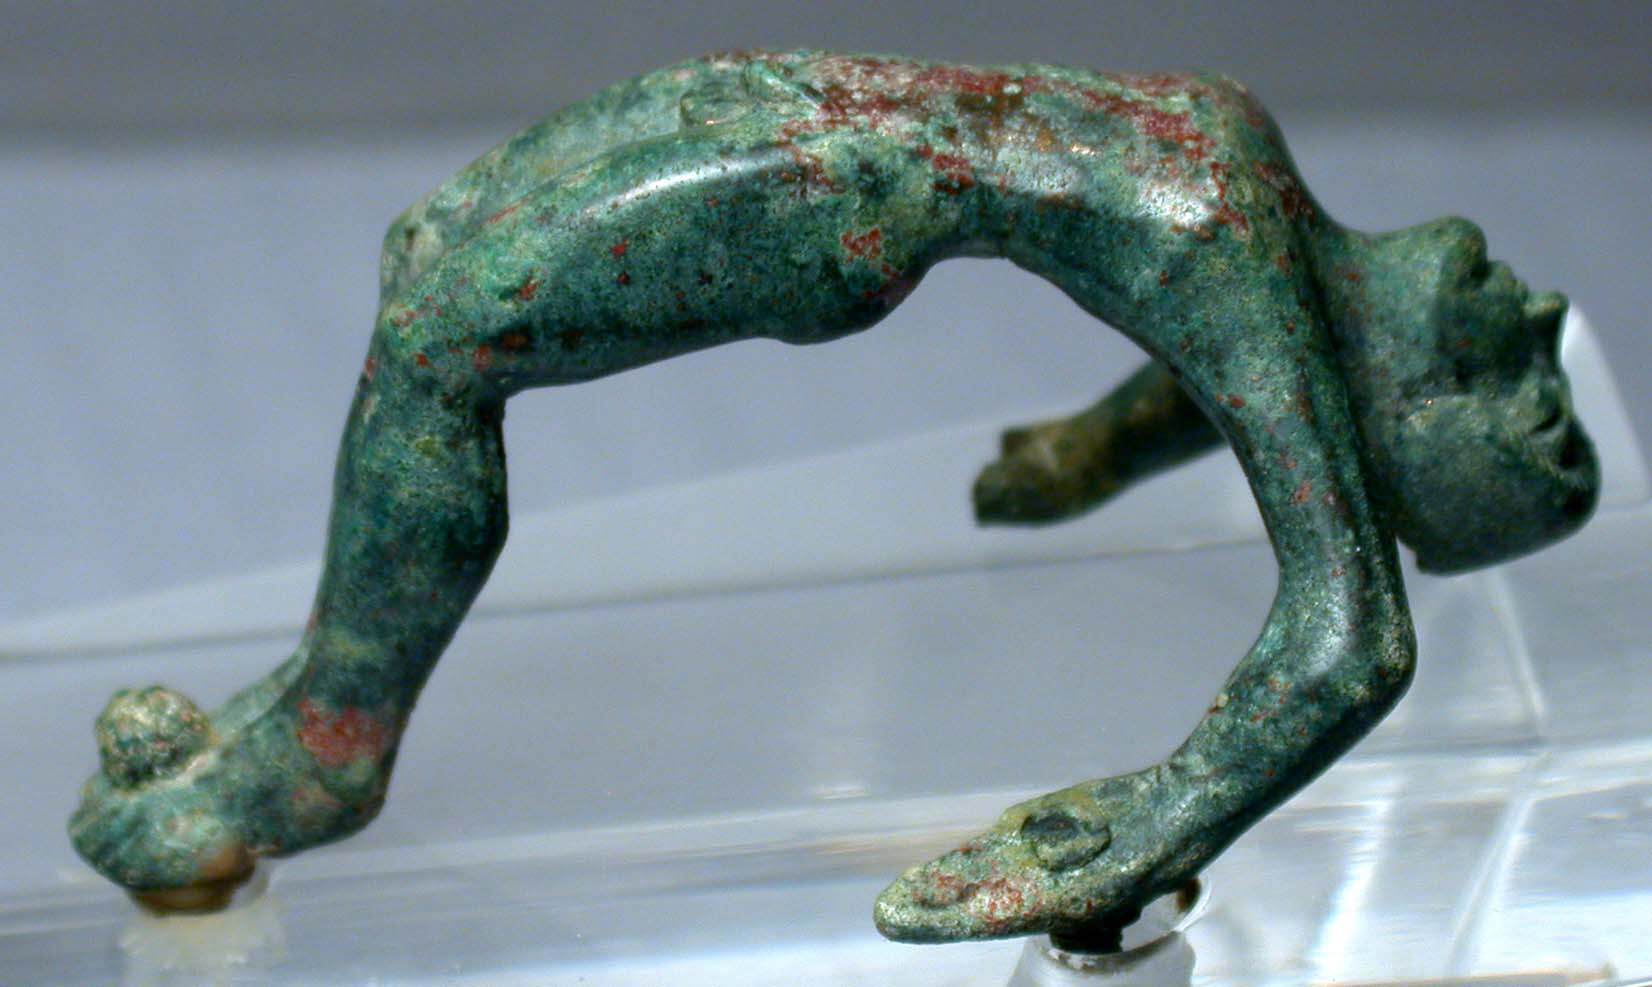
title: Bronze handle of a cista with nude youth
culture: italic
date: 400-301 BCE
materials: bronze